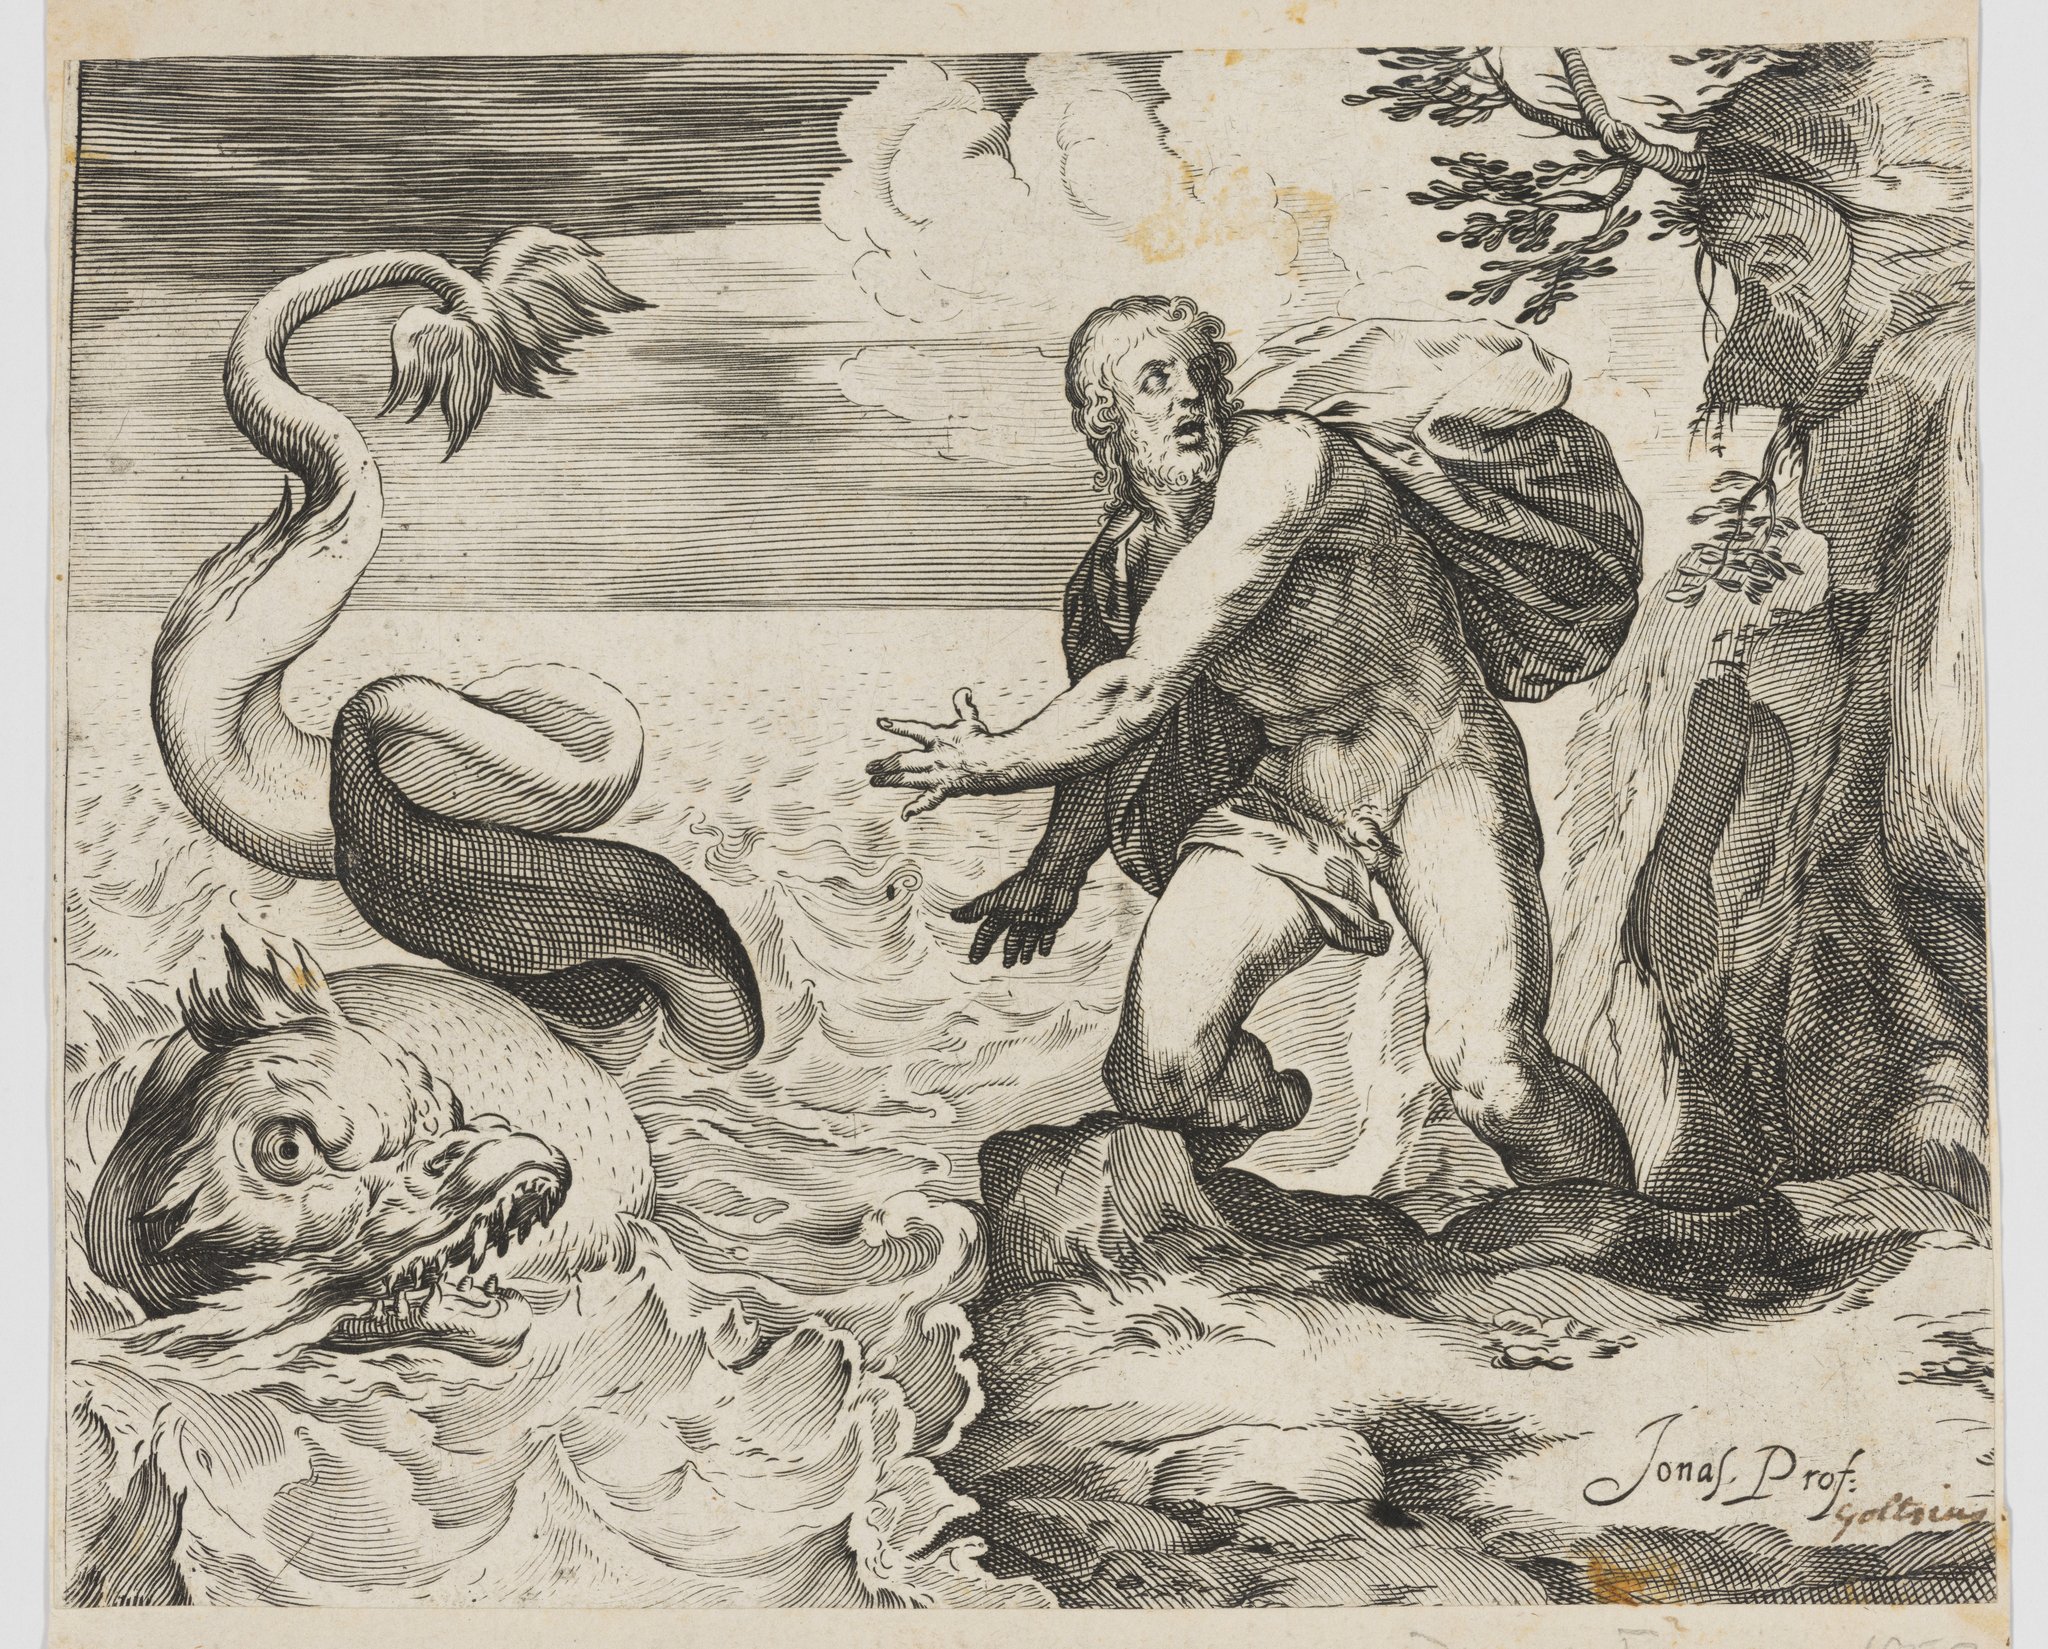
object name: print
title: Jonah and the Whale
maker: luca ciamberlano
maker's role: artist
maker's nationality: italian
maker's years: 1599-1641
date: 1600-1640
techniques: engraving